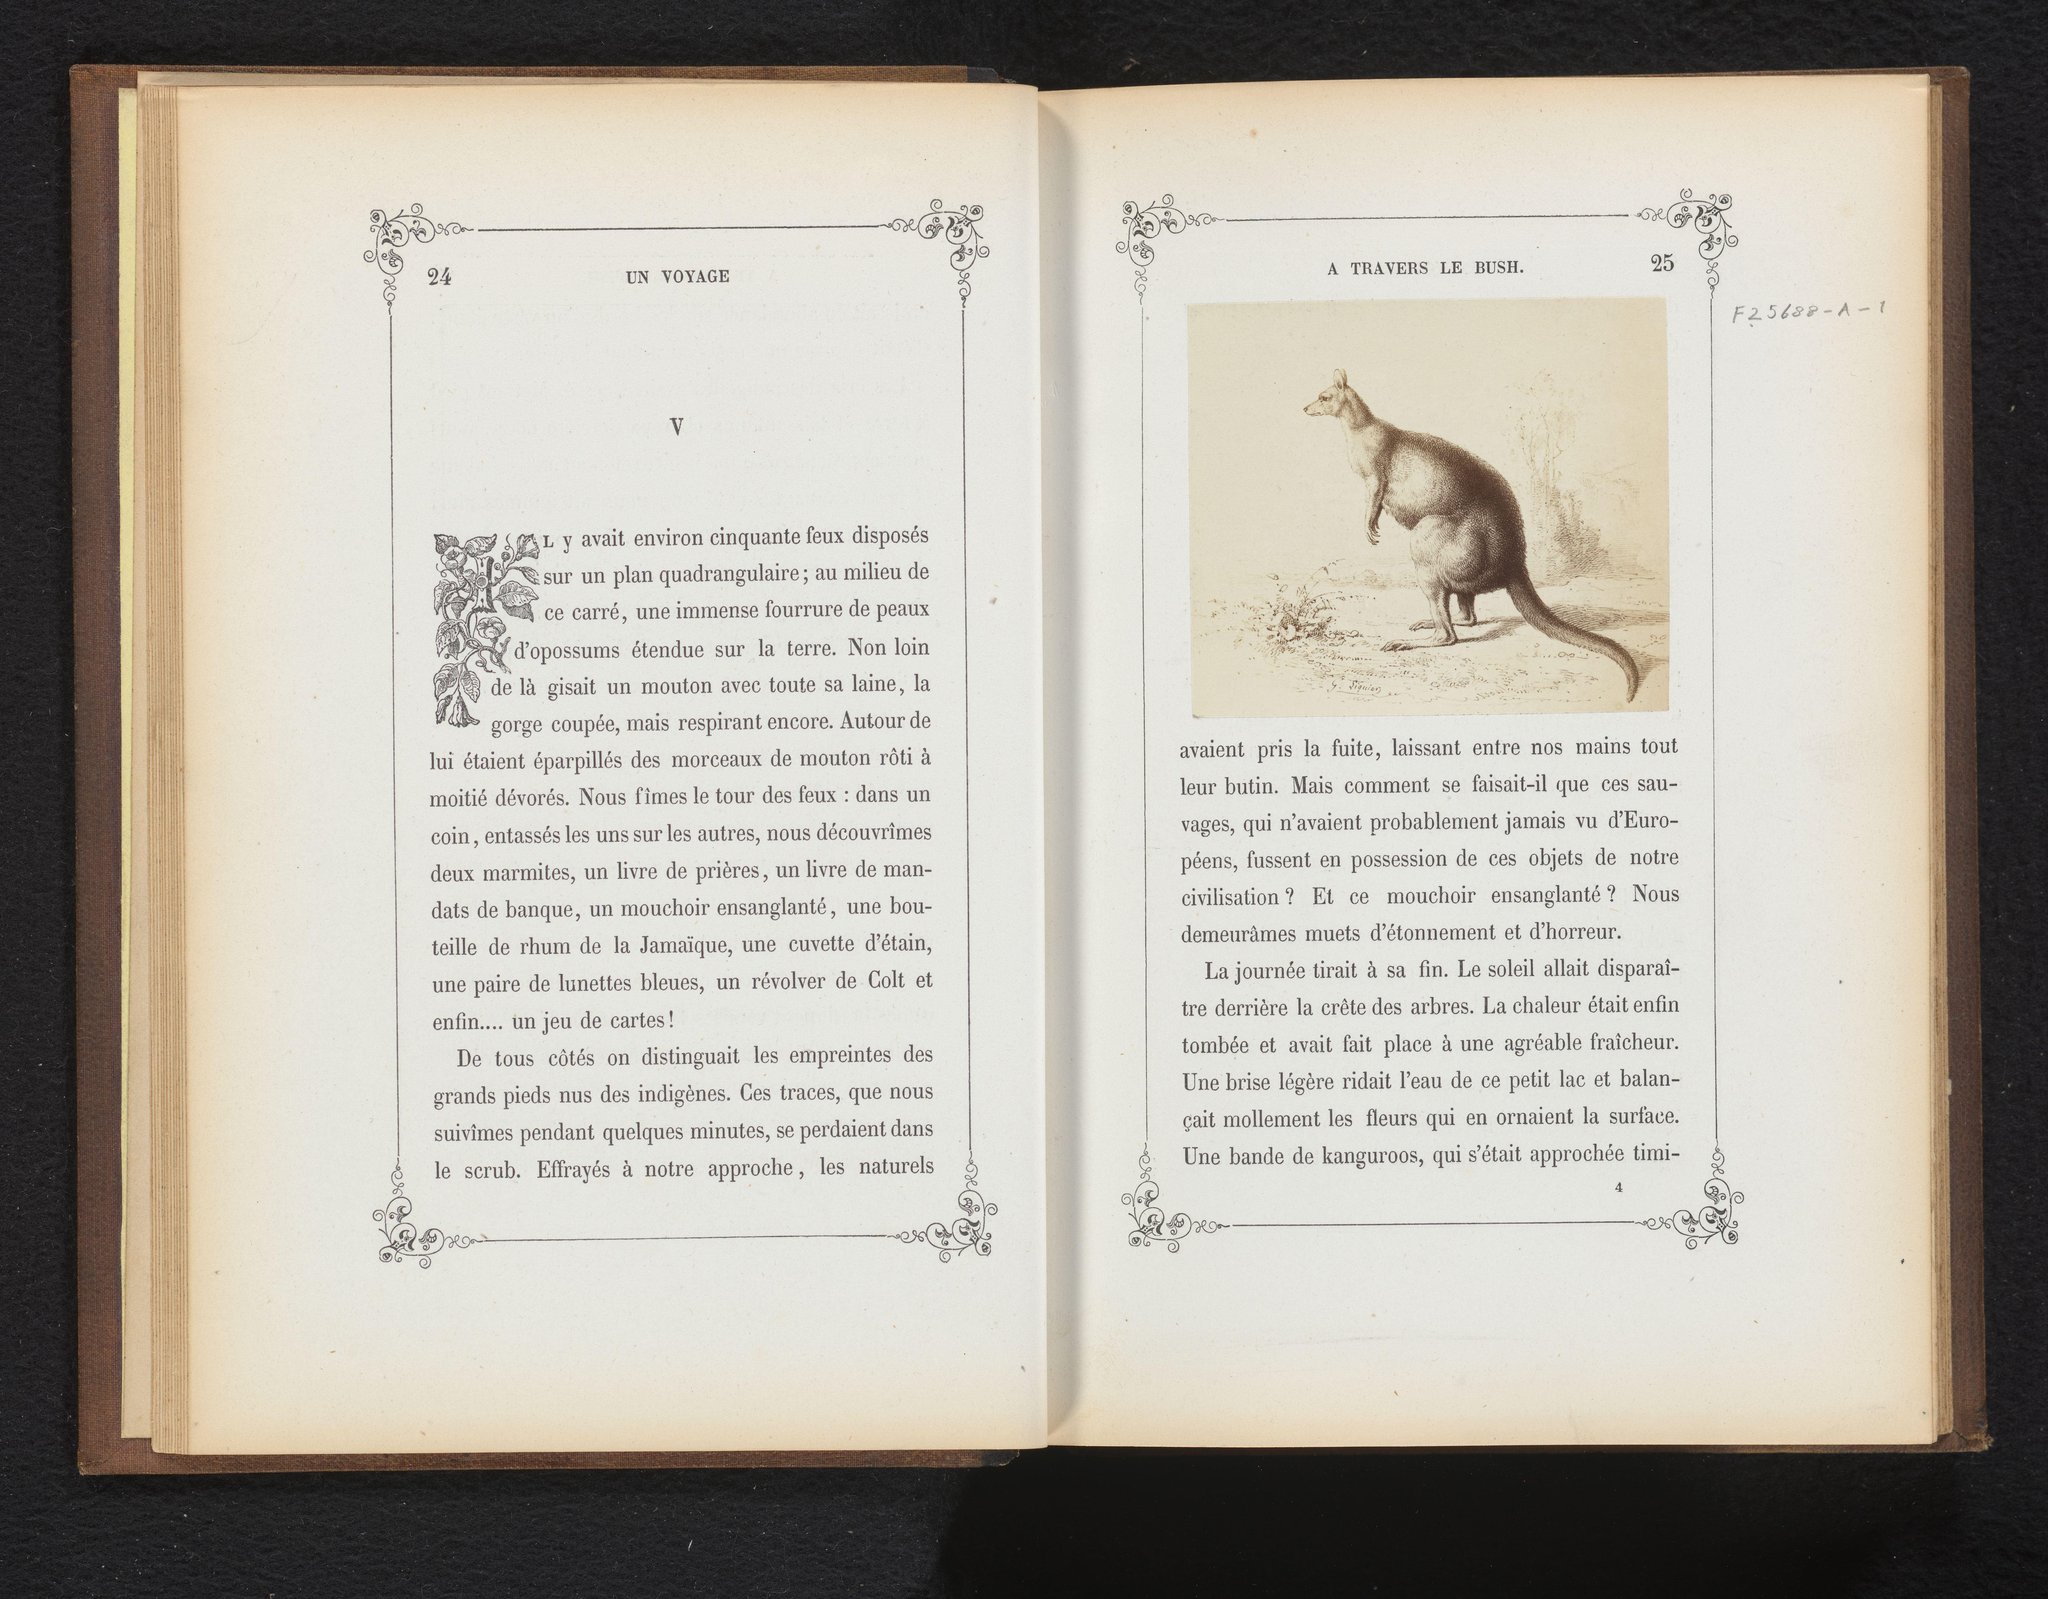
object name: page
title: Fotoreproductie van een tekening van een kangoeroe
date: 1863-1868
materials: paper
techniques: albumen print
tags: other mammals (with name), australia